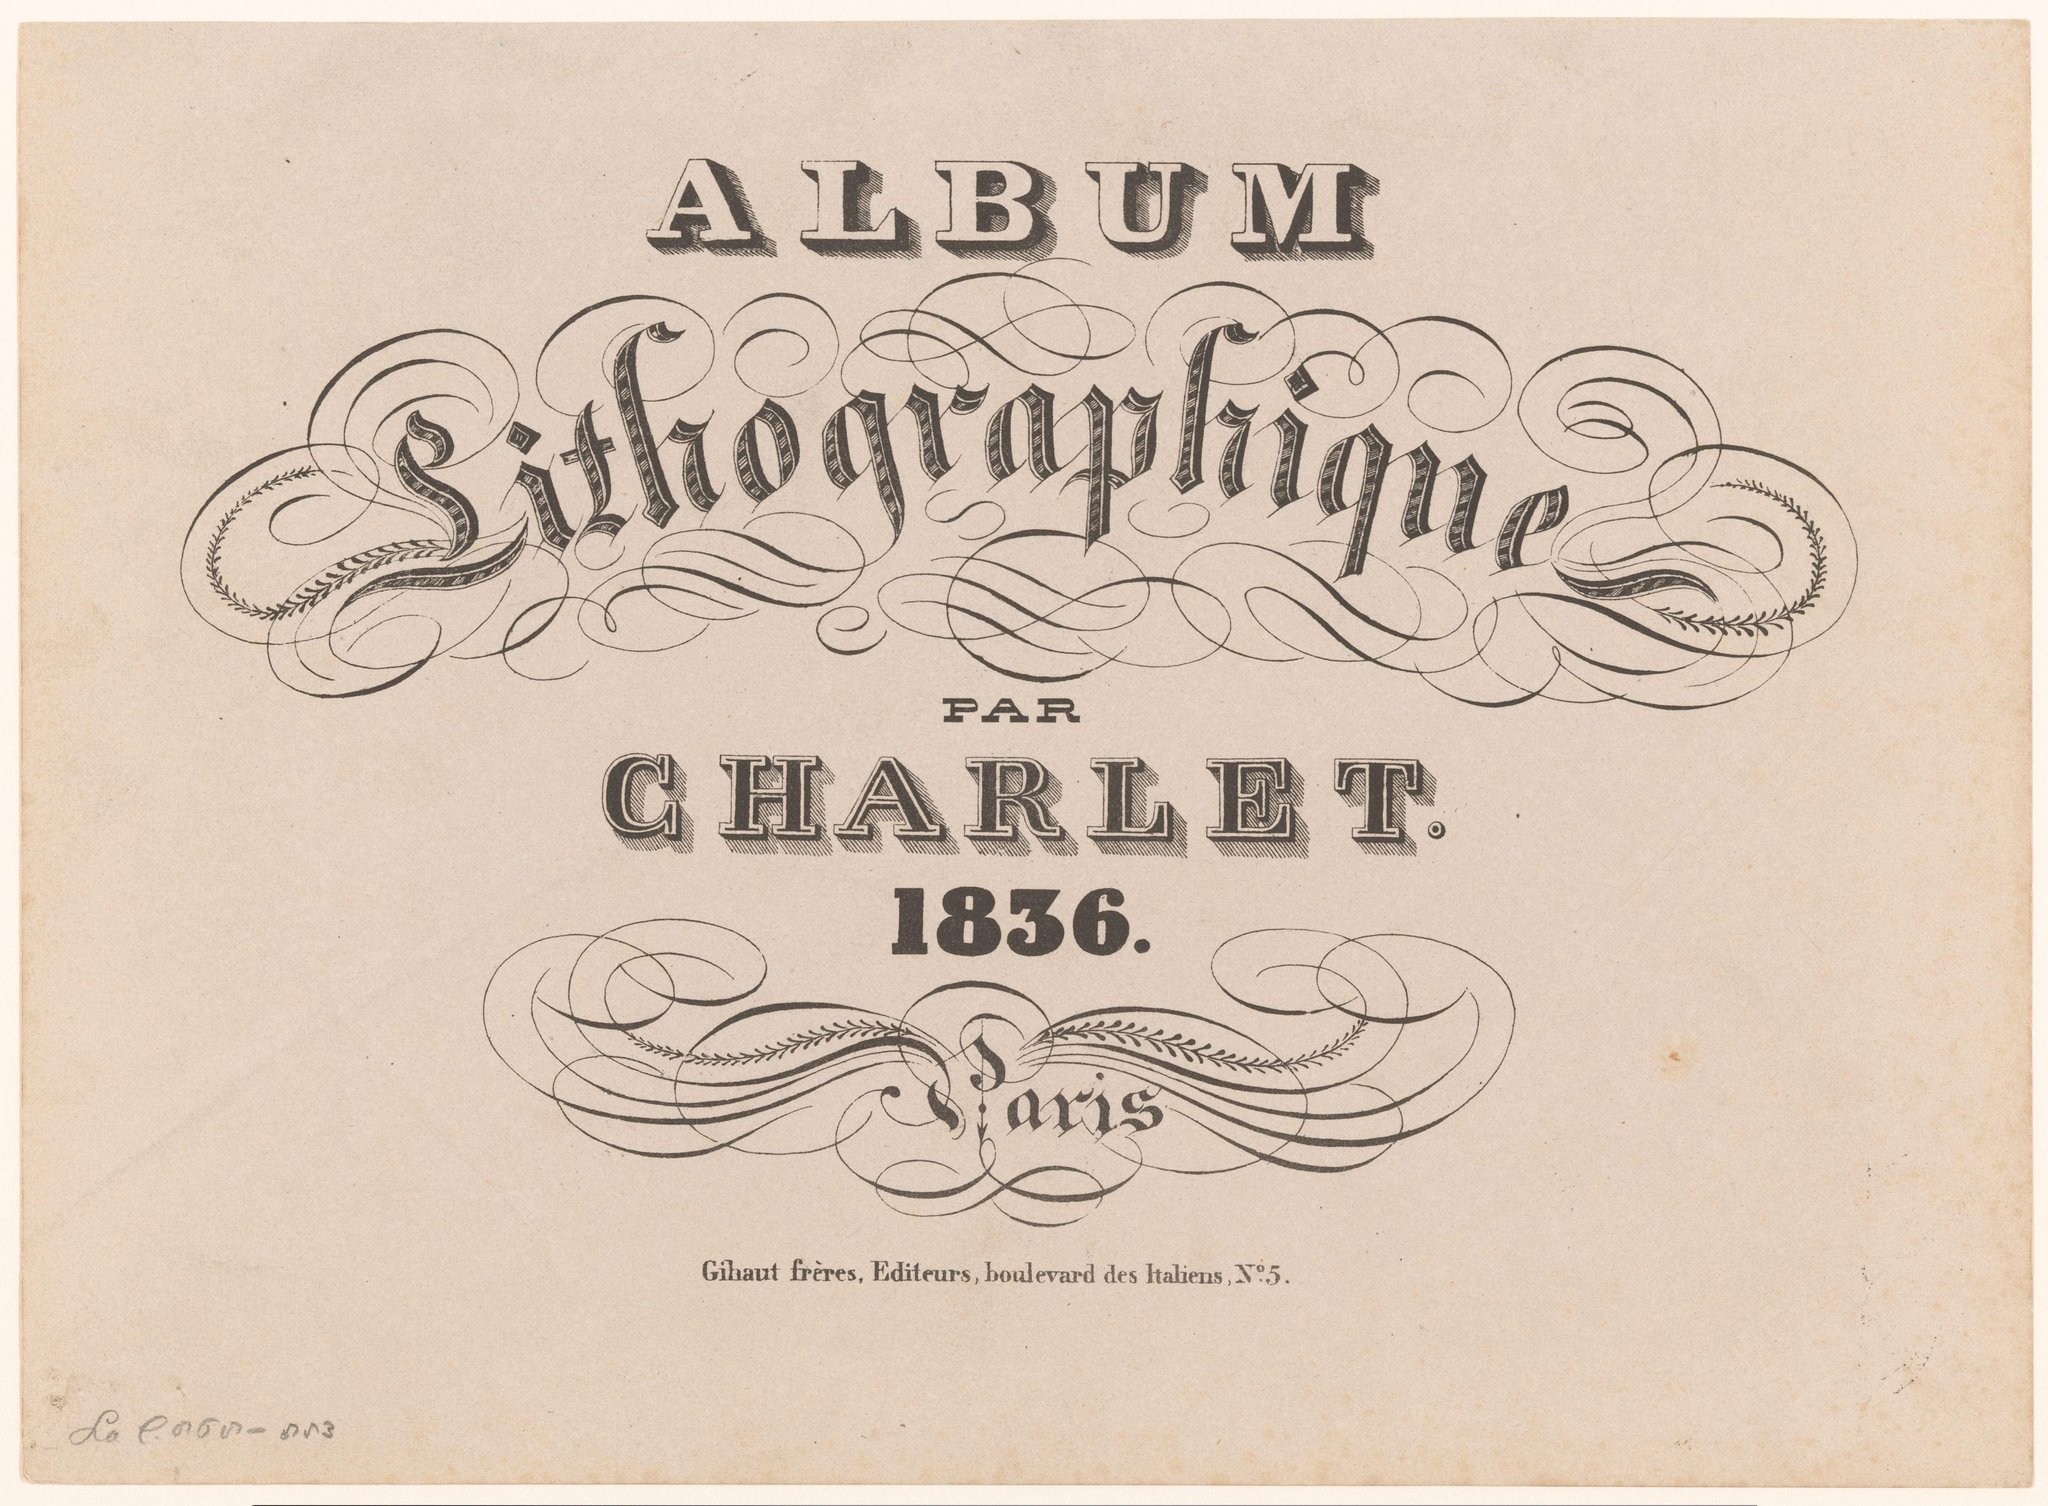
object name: wrapper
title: Album lithographique par Charlet 1836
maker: nicolas toussaint charlet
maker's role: draughtsman, painter, print maker, printer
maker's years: 1792-1845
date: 1836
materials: paper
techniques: pen lithography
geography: paris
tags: calligraphy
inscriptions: date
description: Omslag met zestien prenten, genummerd 1 tot en met 16.